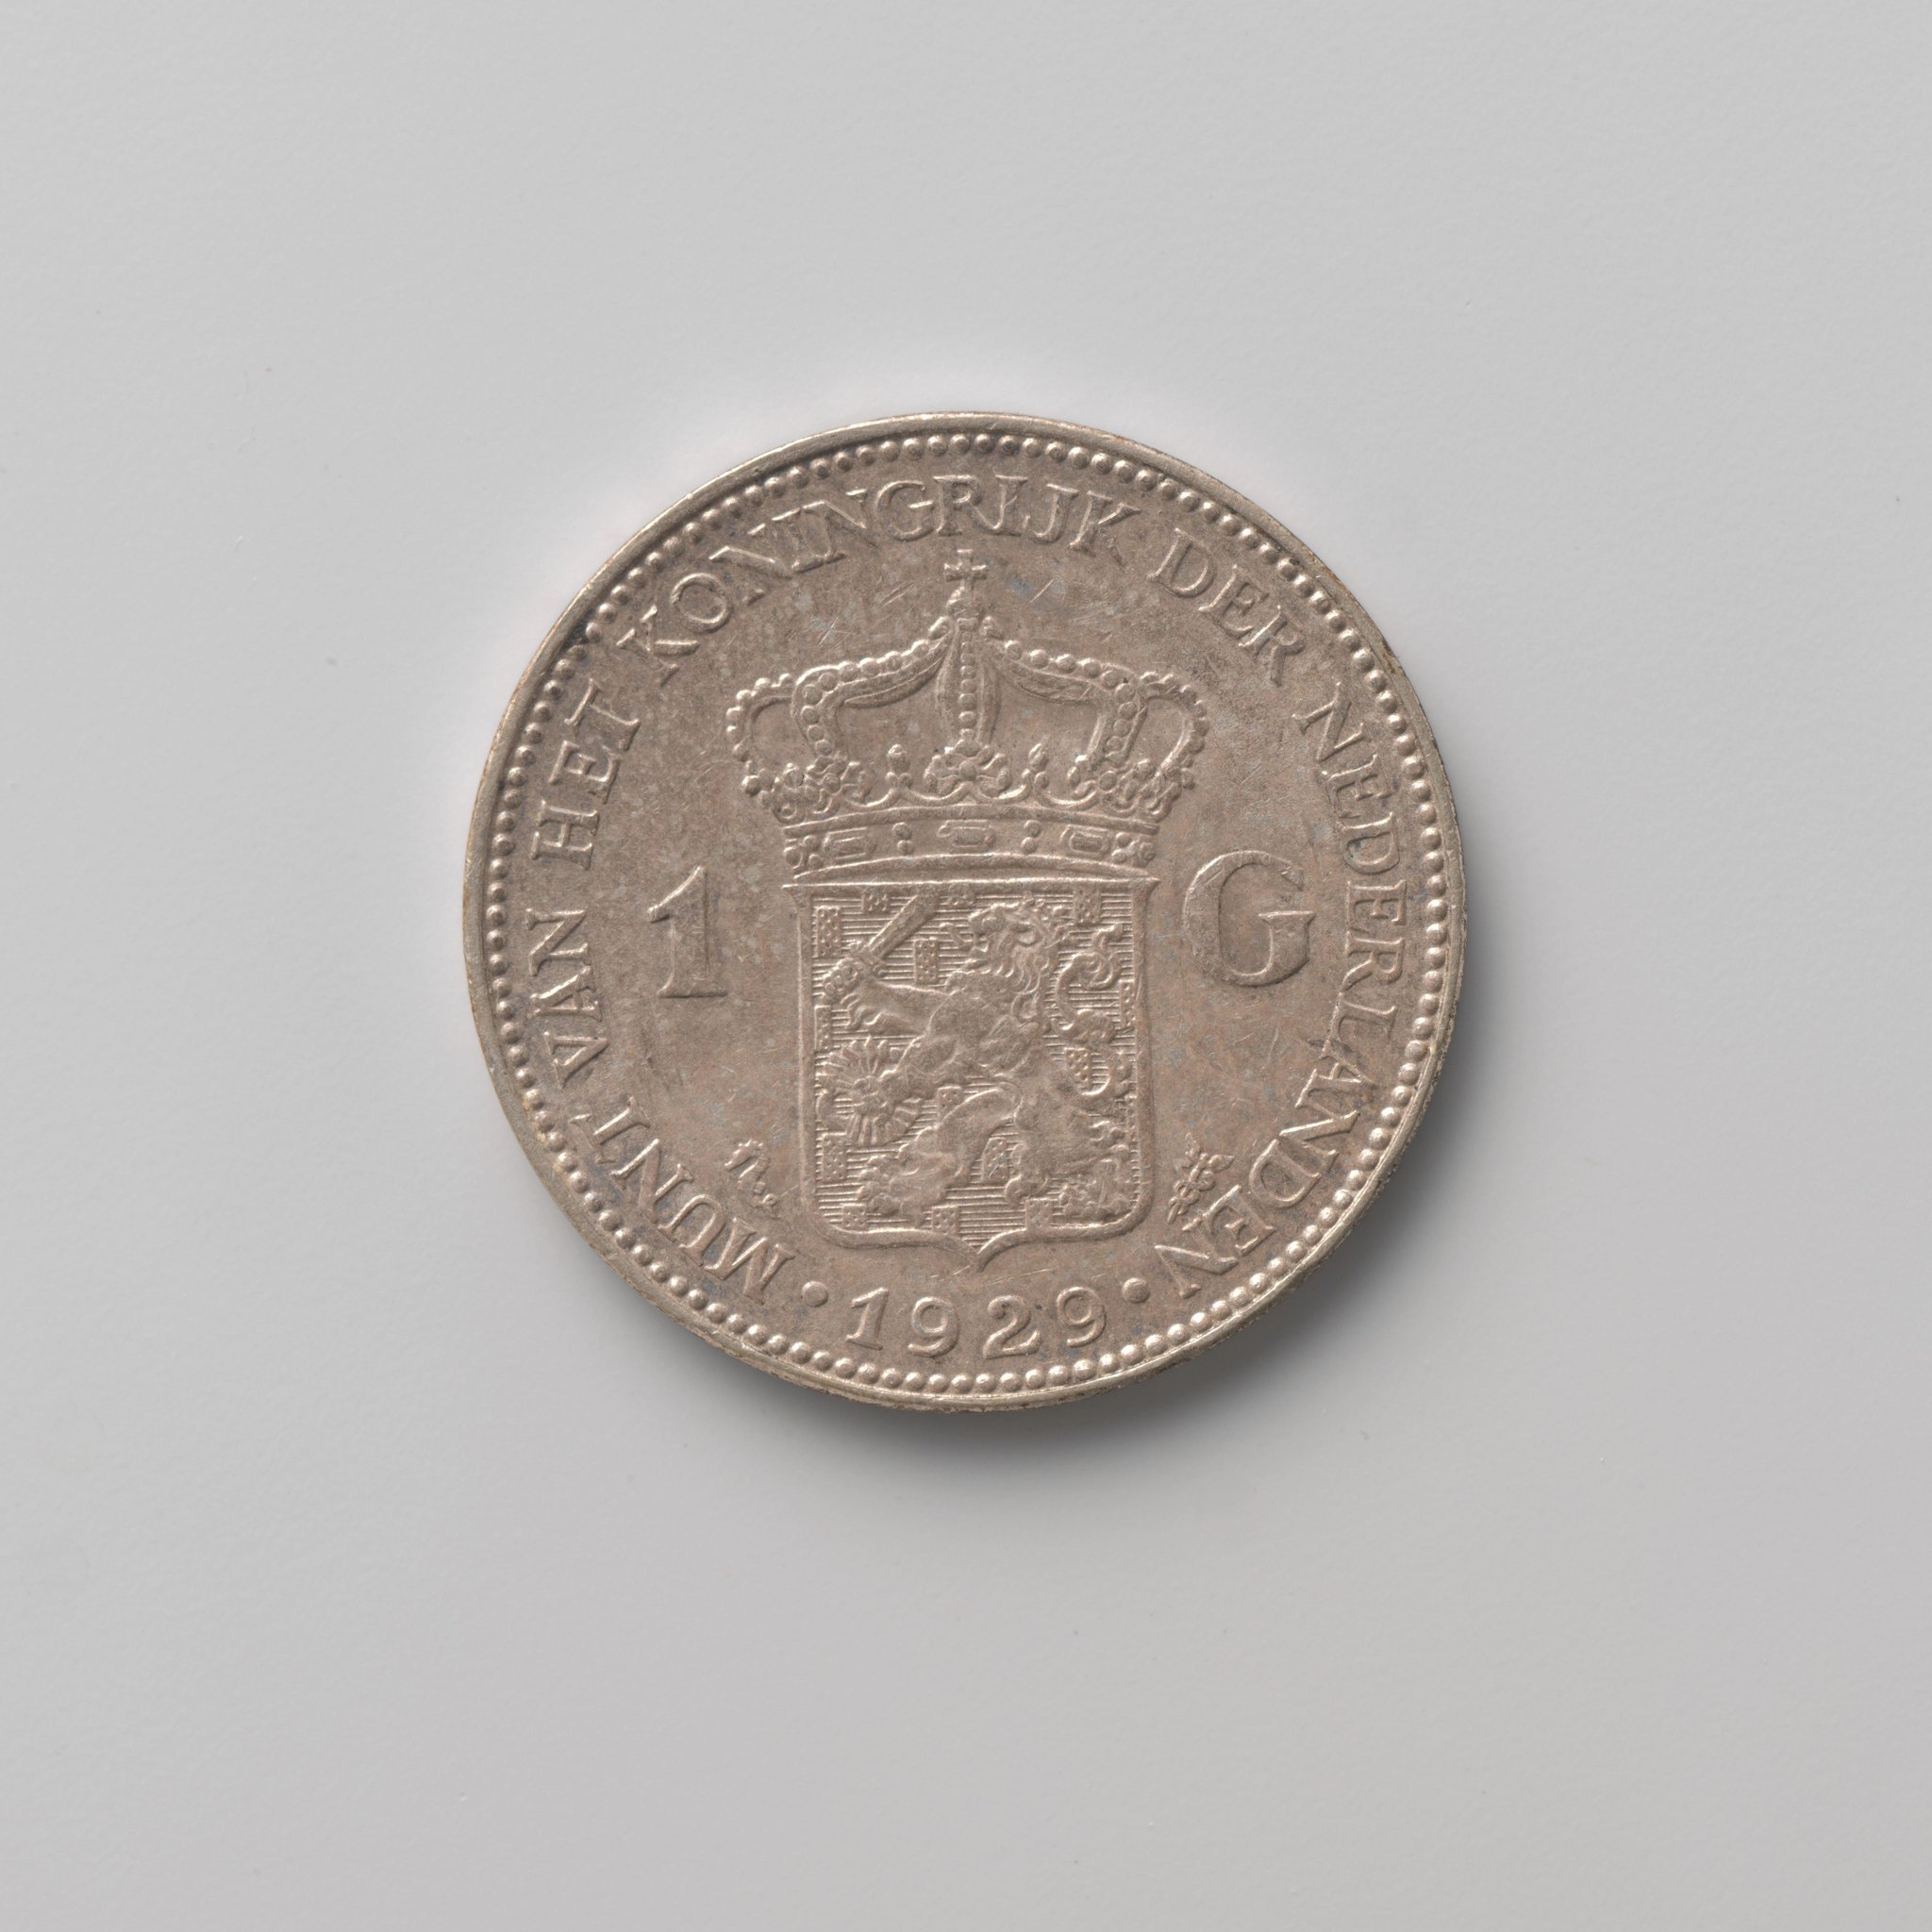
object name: gulden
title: Nederland, gulden,1929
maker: wilhelmina of the netherlands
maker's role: print maker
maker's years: 1880-1962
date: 1929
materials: silver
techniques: striking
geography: utrecht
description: Zilveren munt. Voorzijde: hoofd naar links. Keerzijde: tussen waarde-aanduiding 1 G gekroond rijkswapenschild. Jaartal onderaan in omschrift. Randschrift.